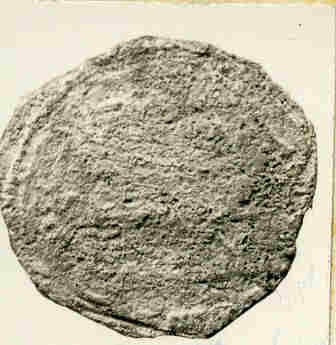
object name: coin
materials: copper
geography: iran